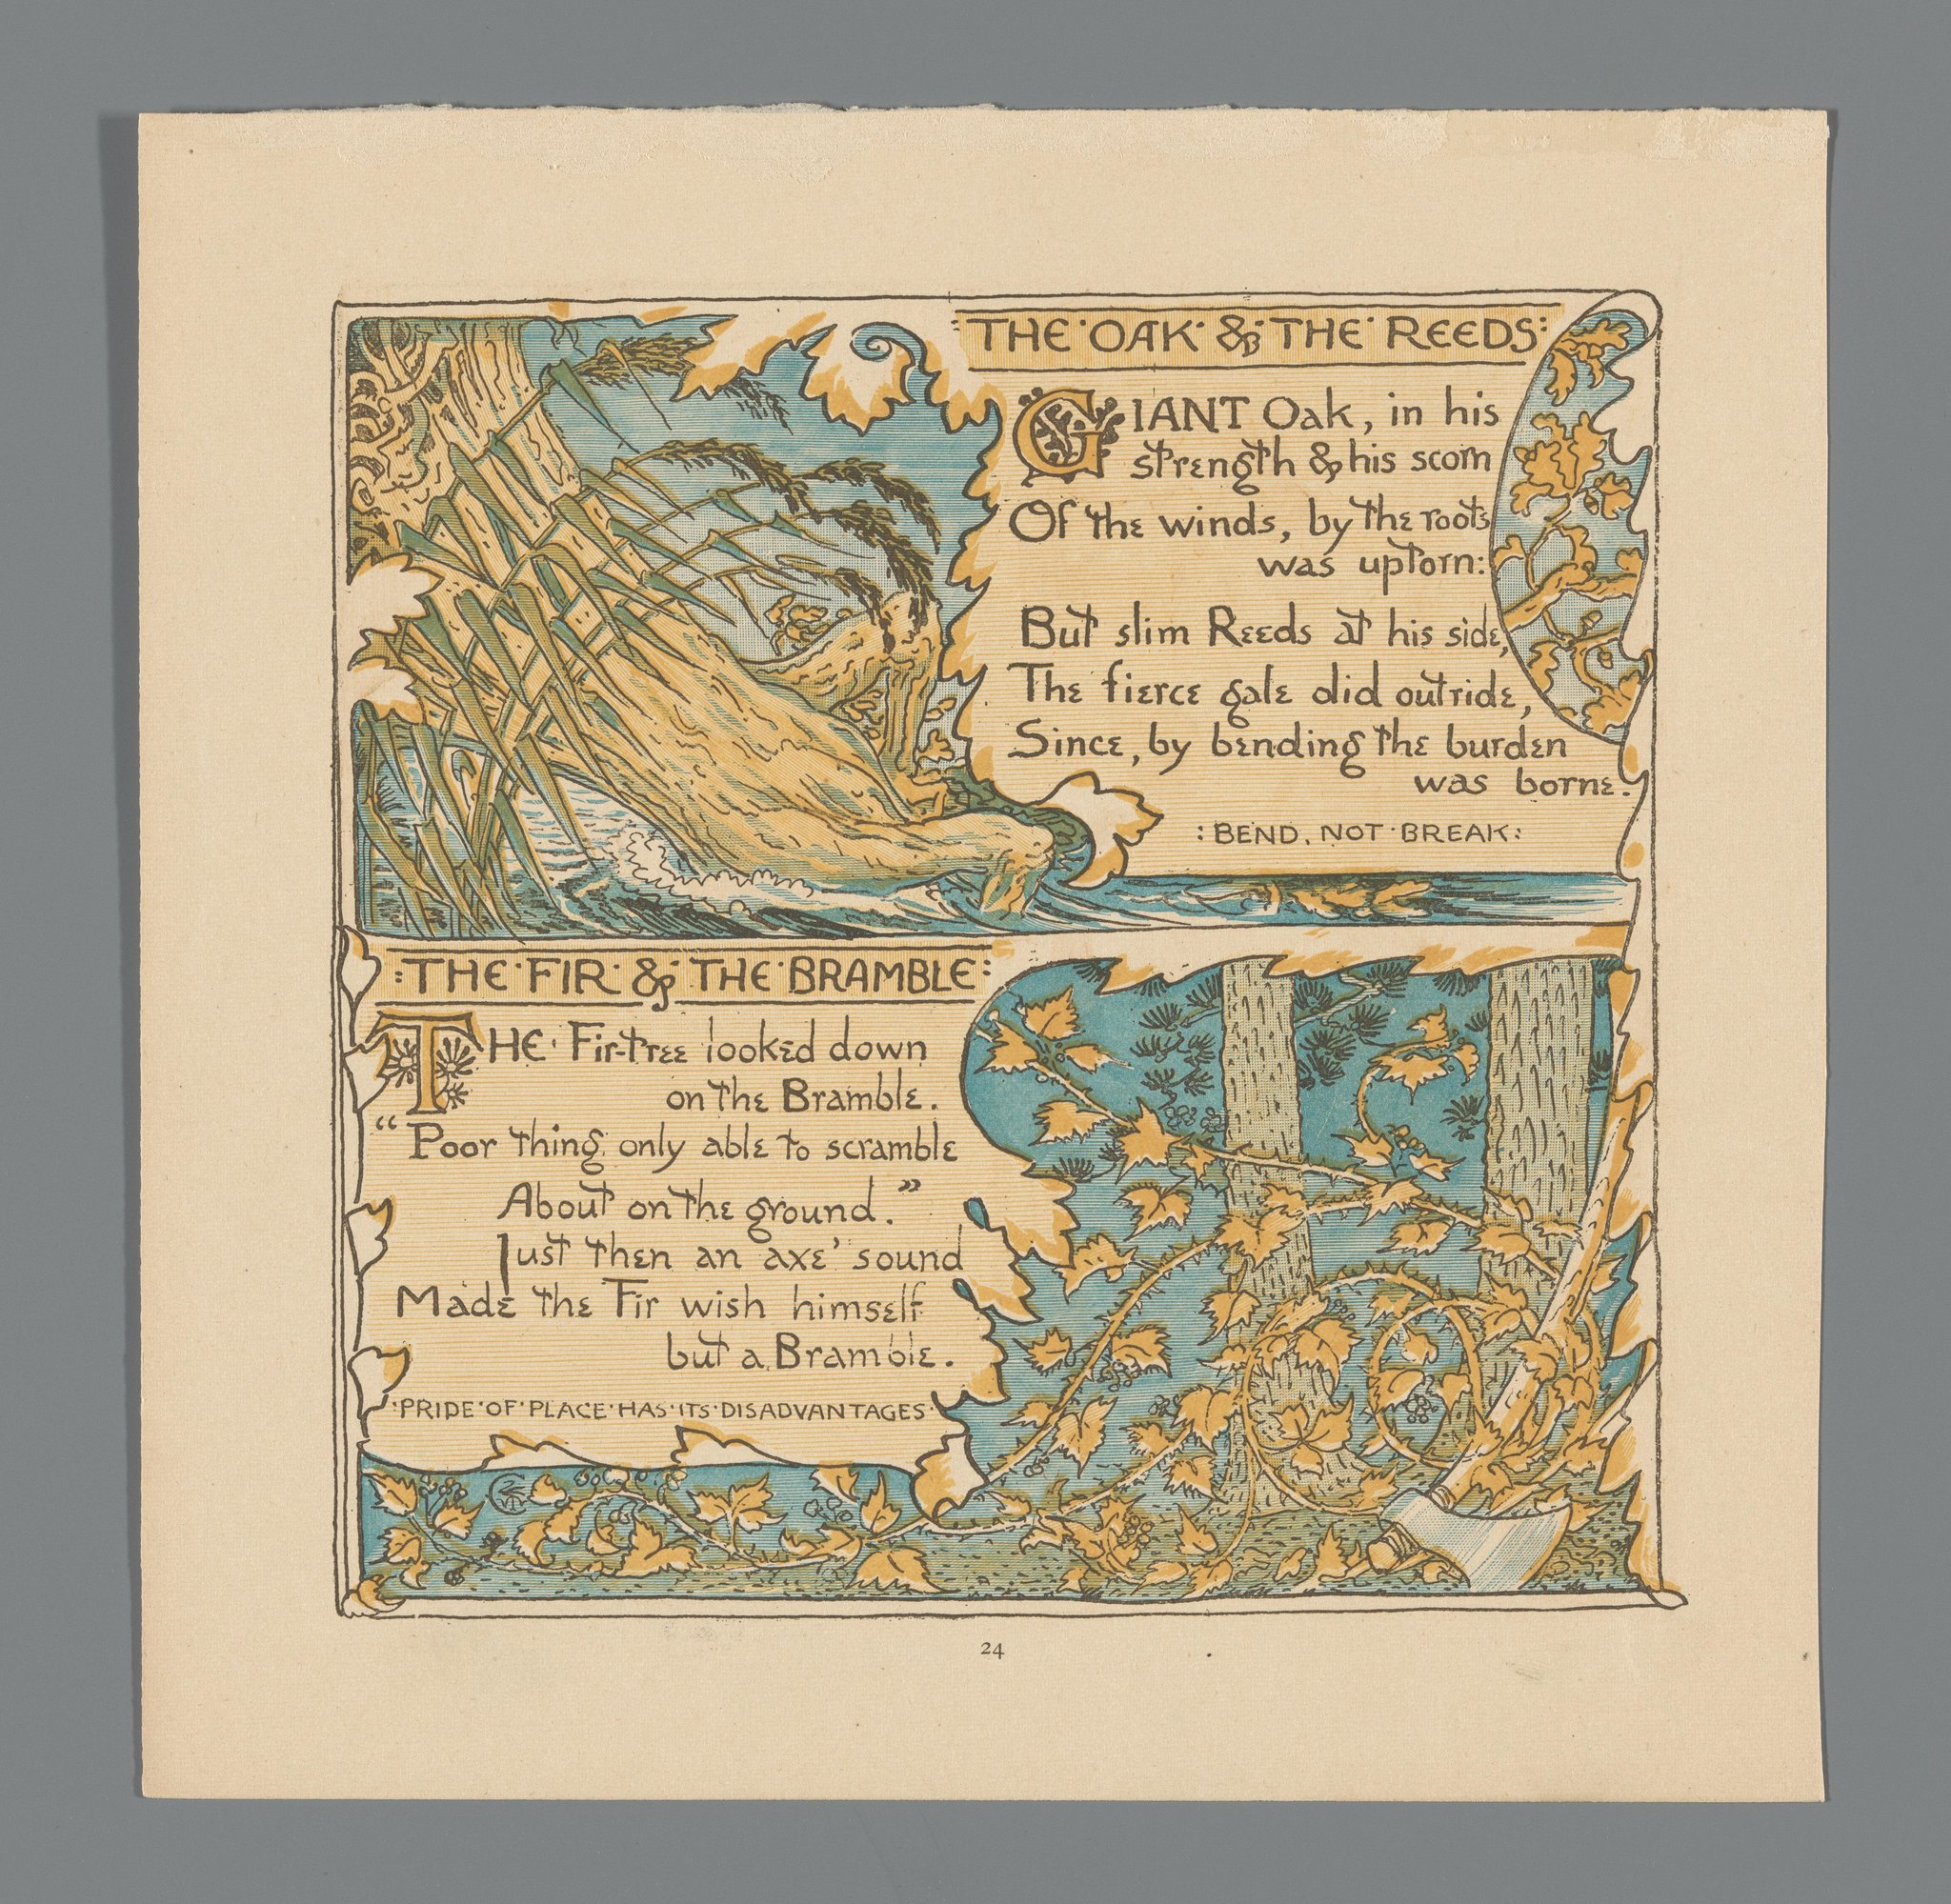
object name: book illustration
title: Eikenboom, riet, den en bramenstruik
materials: paper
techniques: wood engraving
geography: london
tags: plants and herbs: bramble, trees: oak, plants and herbs: reed, trees: fir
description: Prent uit: The baby's own Aesop being the fables condensed in rhyme. Londen: Routledge & Sons, 1887. Of een latere uitgave.